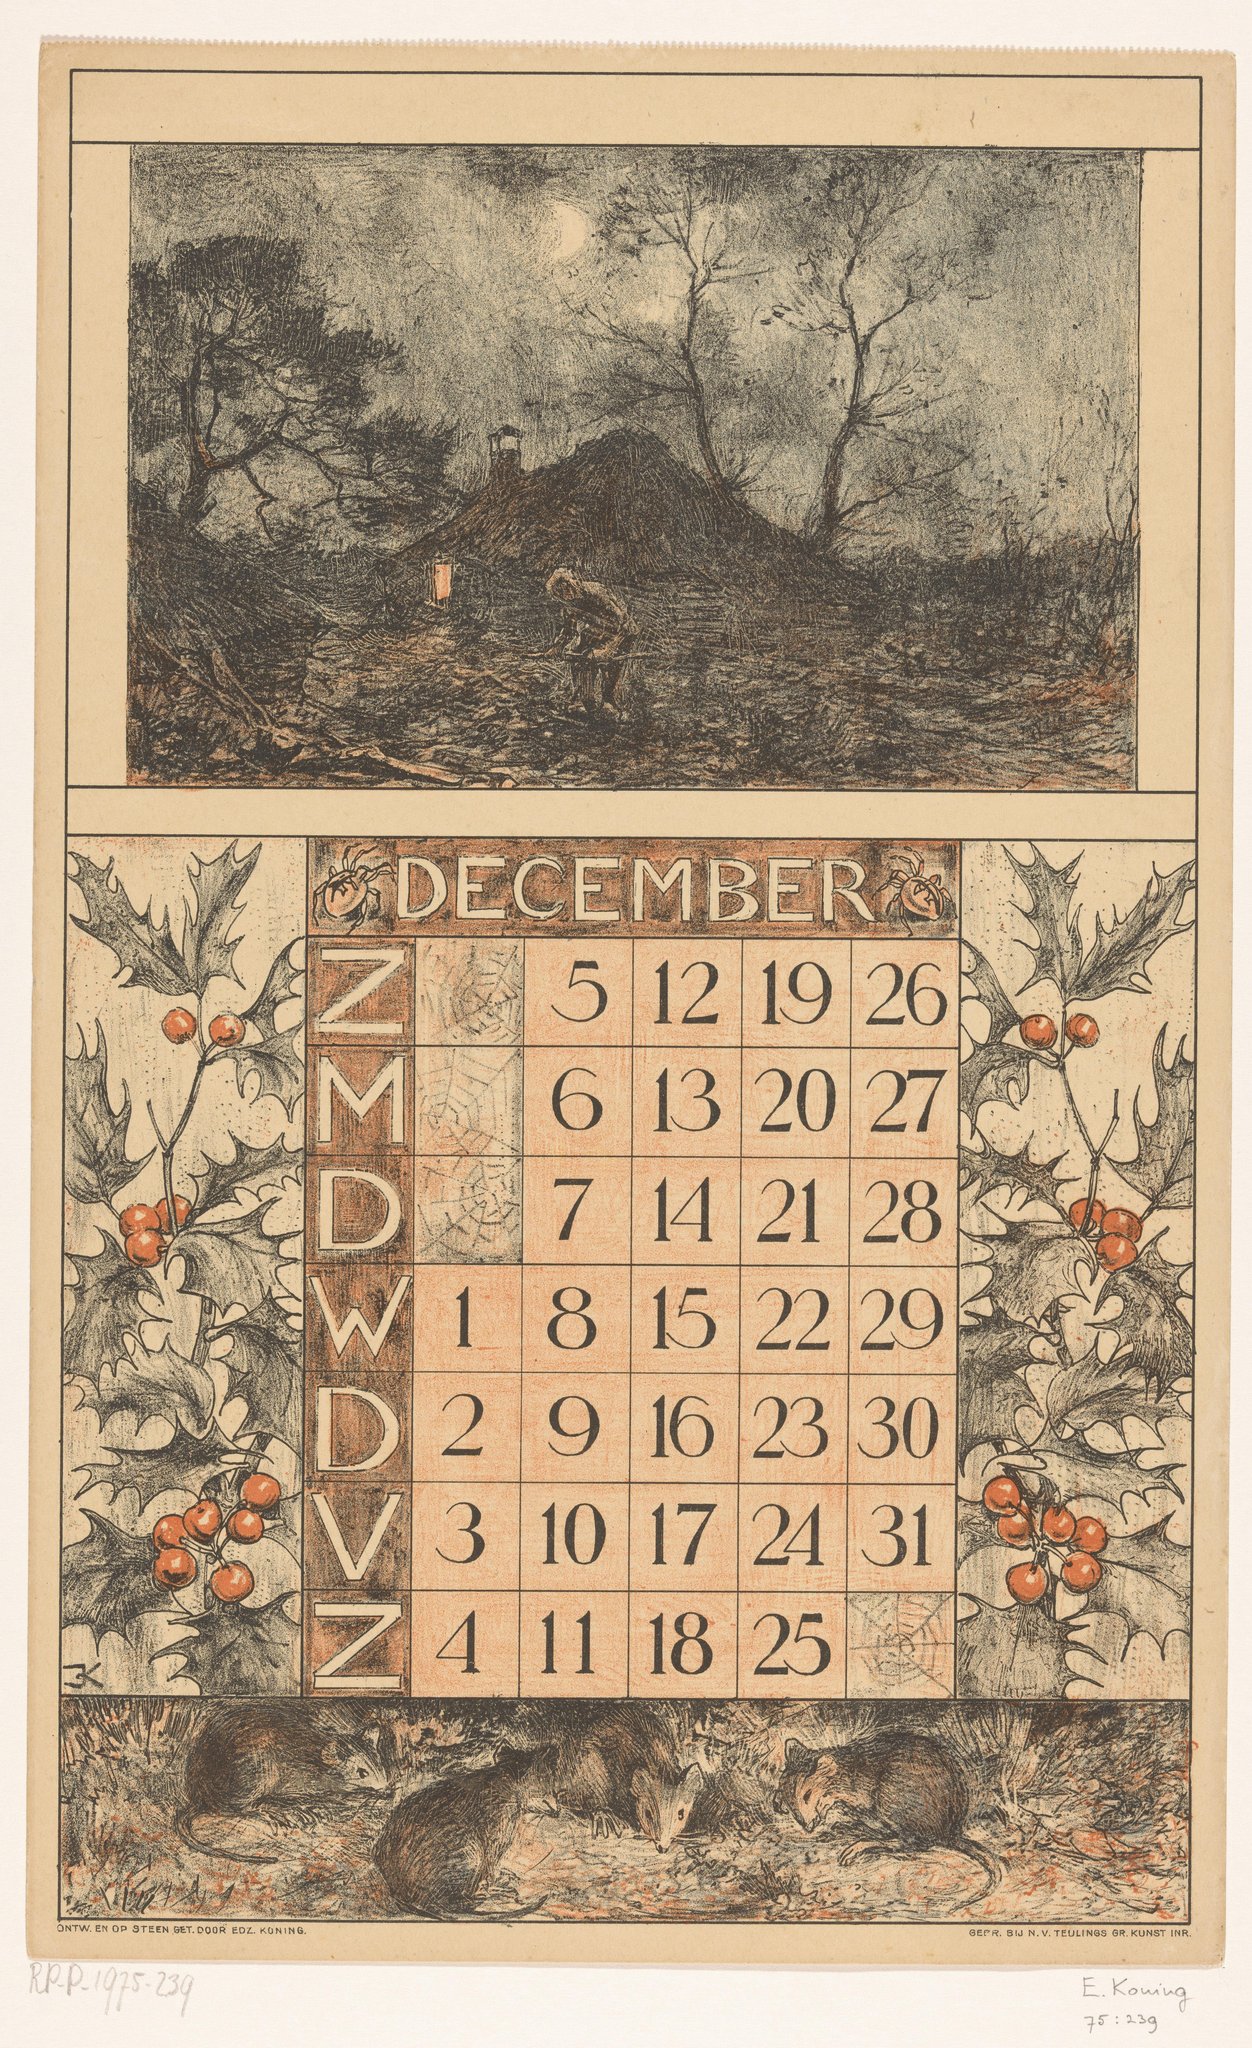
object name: calendar leaf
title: Kalenderblad voor december 1920 van de Nederlandsche Gist- en Spiritusfabriek in Delft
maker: edzard koning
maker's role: draughtsman, print maker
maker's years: 1869-1954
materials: paper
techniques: lithograph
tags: woodgathering, woodgatherer, rodents: mouse, shrubs: holly, darkness, spiders, farm or solitary house in landscape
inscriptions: collector's mark: Lugt 2228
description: Een vierkant kader opgevuld met de dagen van de maand december en daaromheen hulst, vier muizen en twee spinnen. Bovenaan een rechthoekig kader met daarin een man die in het donker hout verzamelt in de buurt van een hut.